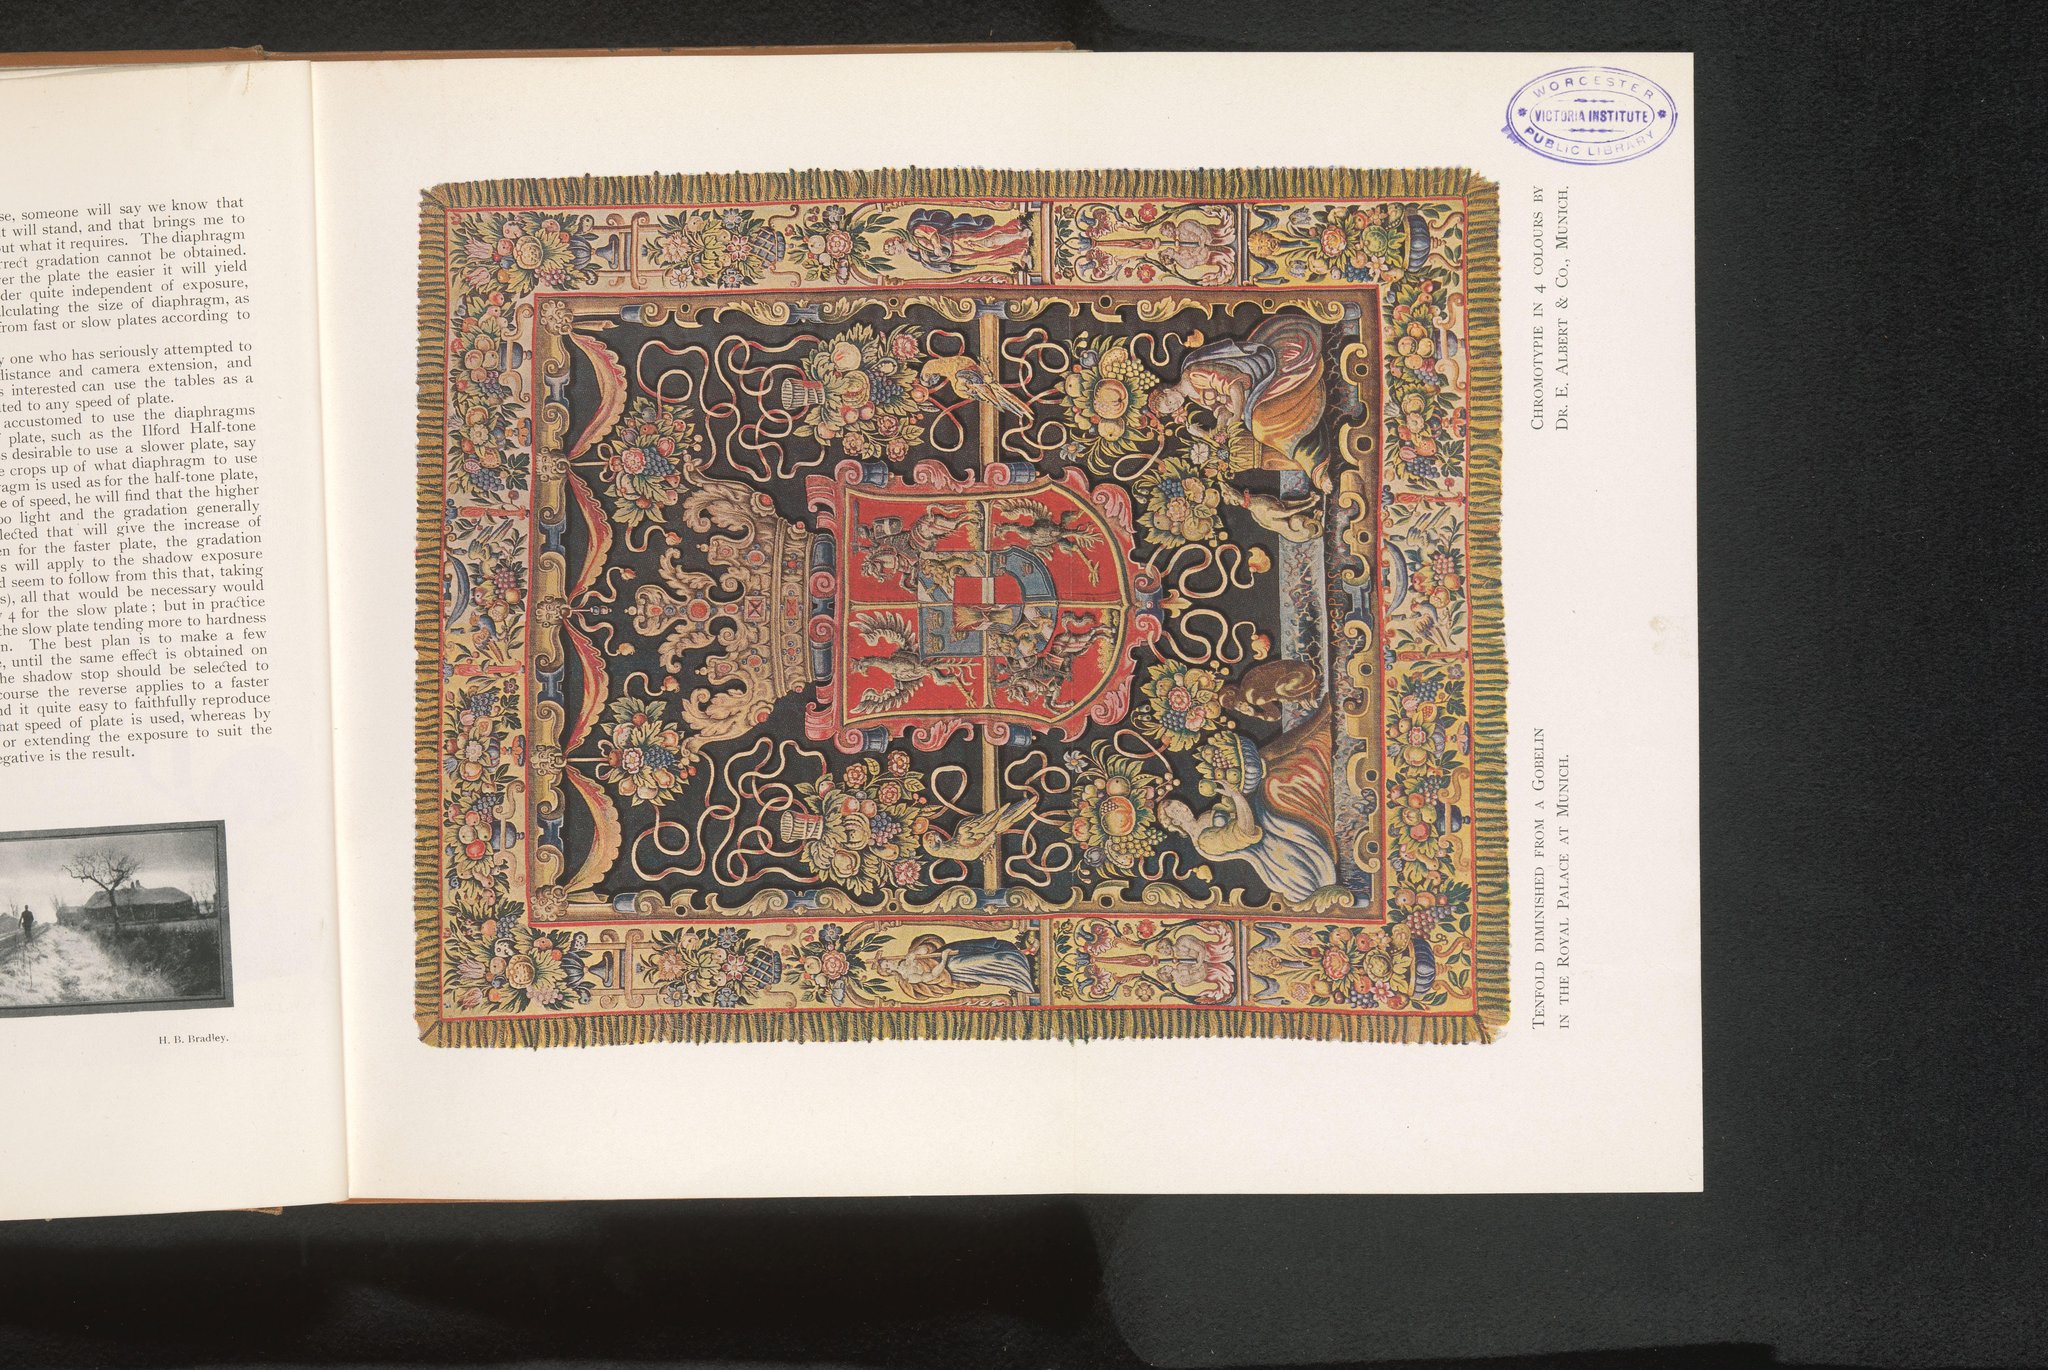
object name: page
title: Tenfold diminished from a Gobelin in the Royal Palace at Munich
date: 1894-1899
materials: paper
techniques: four-color autotype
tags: tapestry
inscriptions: collector's mark: ‘Worcester Public Library/ Victoria's Institute’